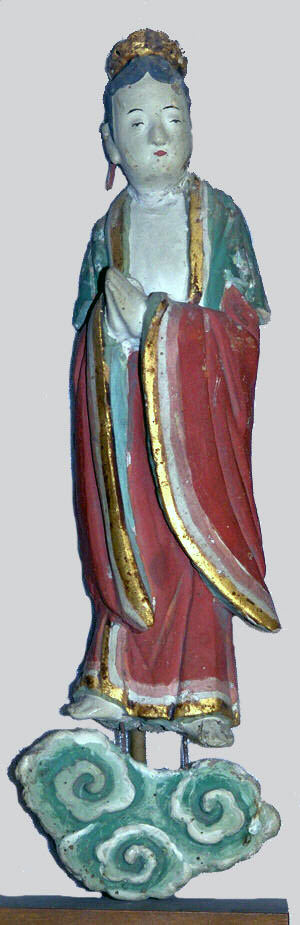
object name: statuette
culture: chinese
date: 1601-1700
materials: mud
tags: men